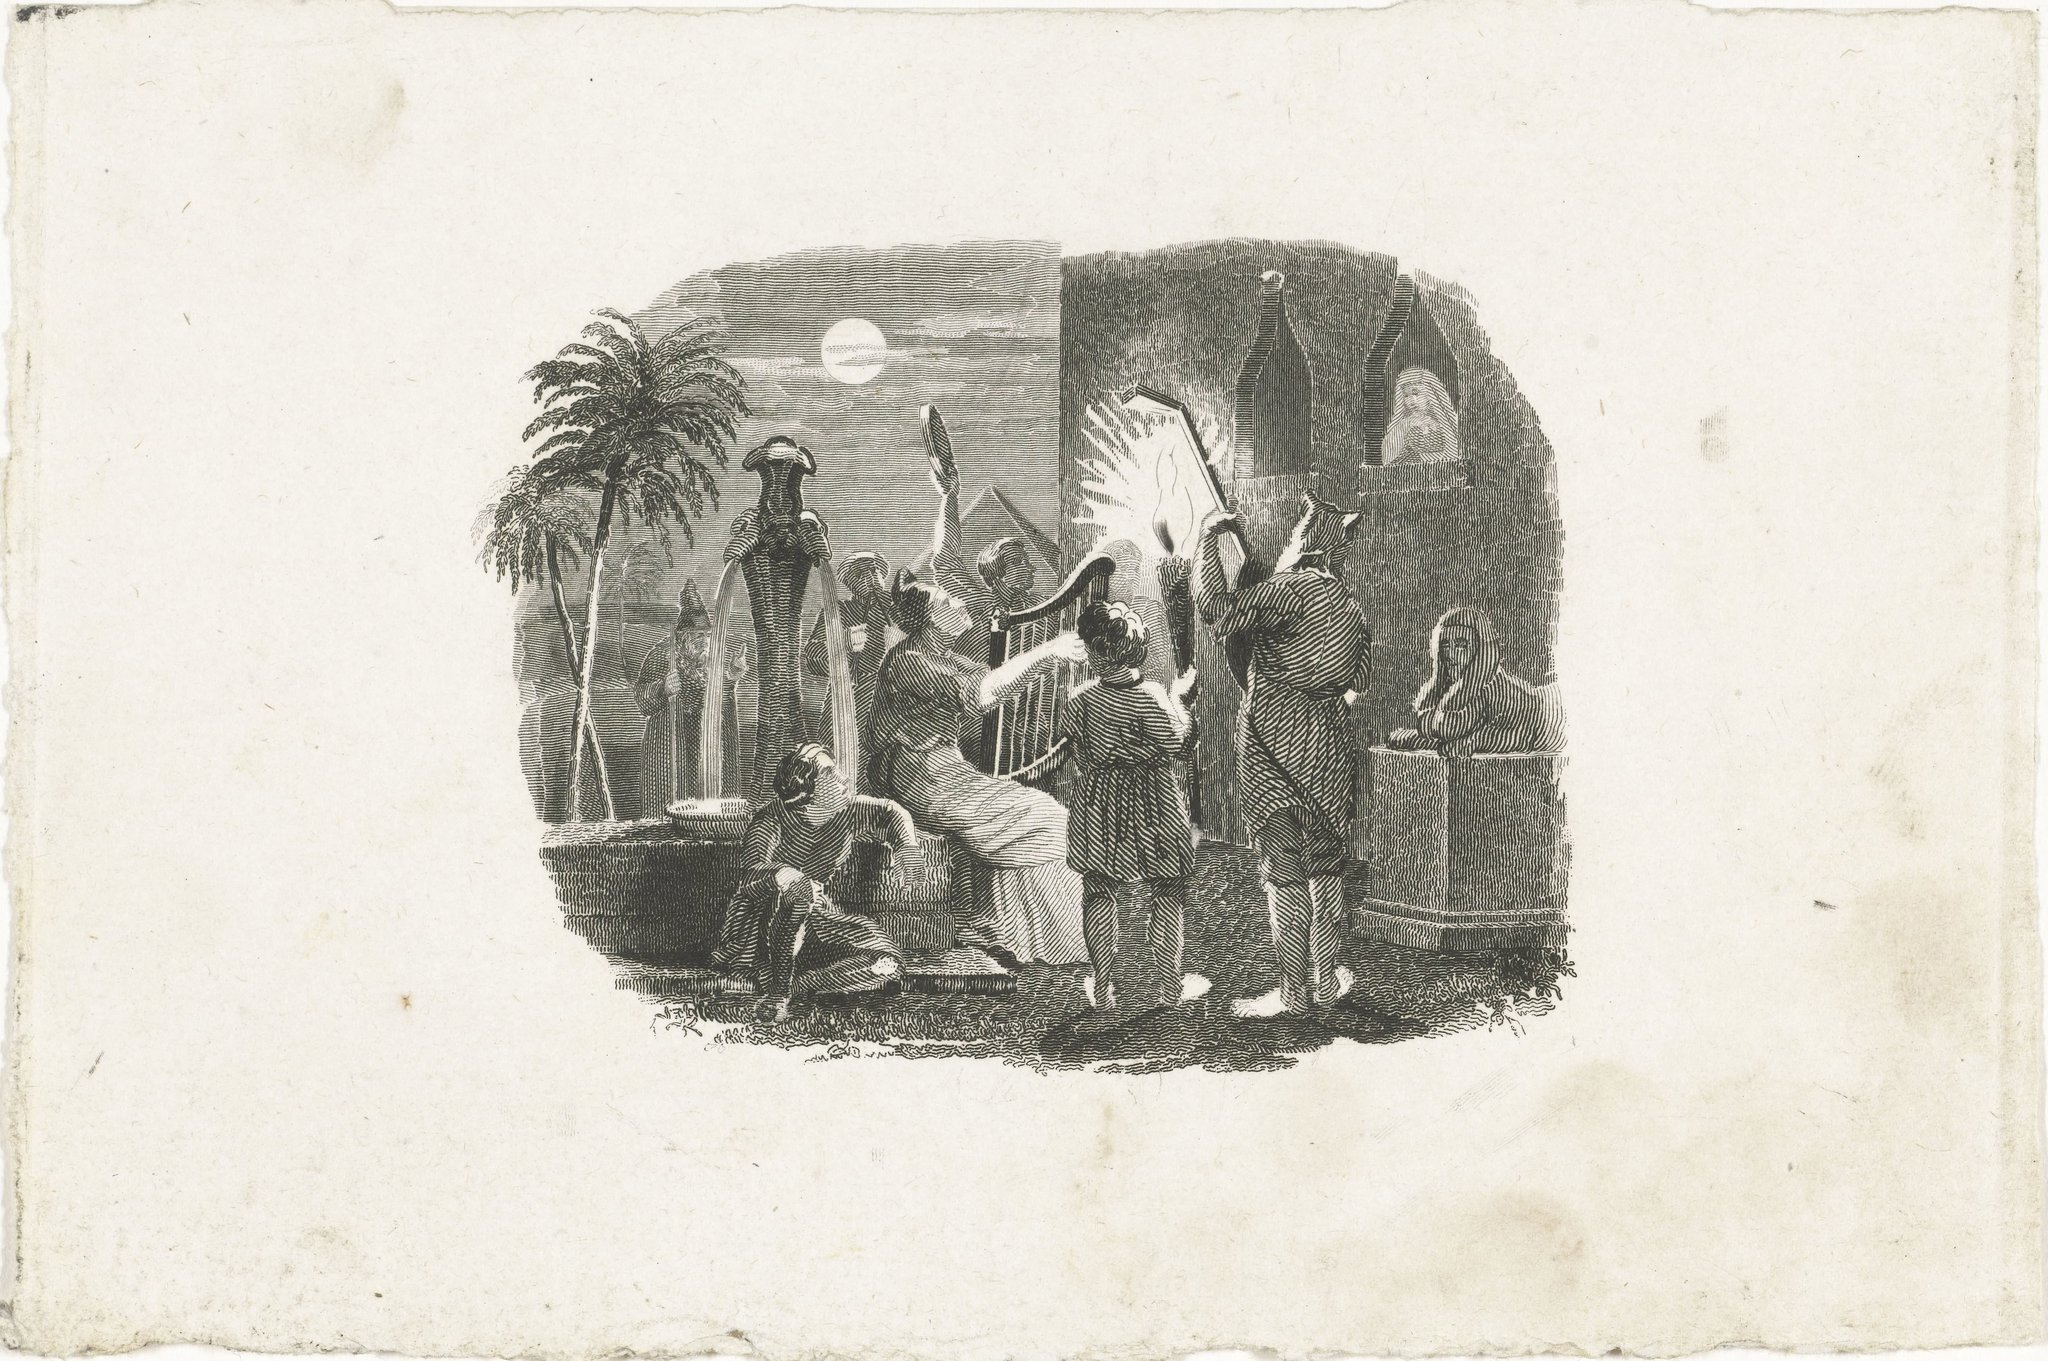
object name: book illustration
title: Groepje muzikanten speelt 's nachts voor het raam van een vrouw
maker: henricus wilhelmus couwenberg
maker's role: draughtsman, print maker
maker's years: 1814-1845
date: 1830-1845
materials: paper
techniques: engraving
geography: amsterdam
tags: small group of musicians, chamber orchestra, jazz band, human figure at (open) window, seen from outside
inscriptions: collector's mark: Lugt 2228